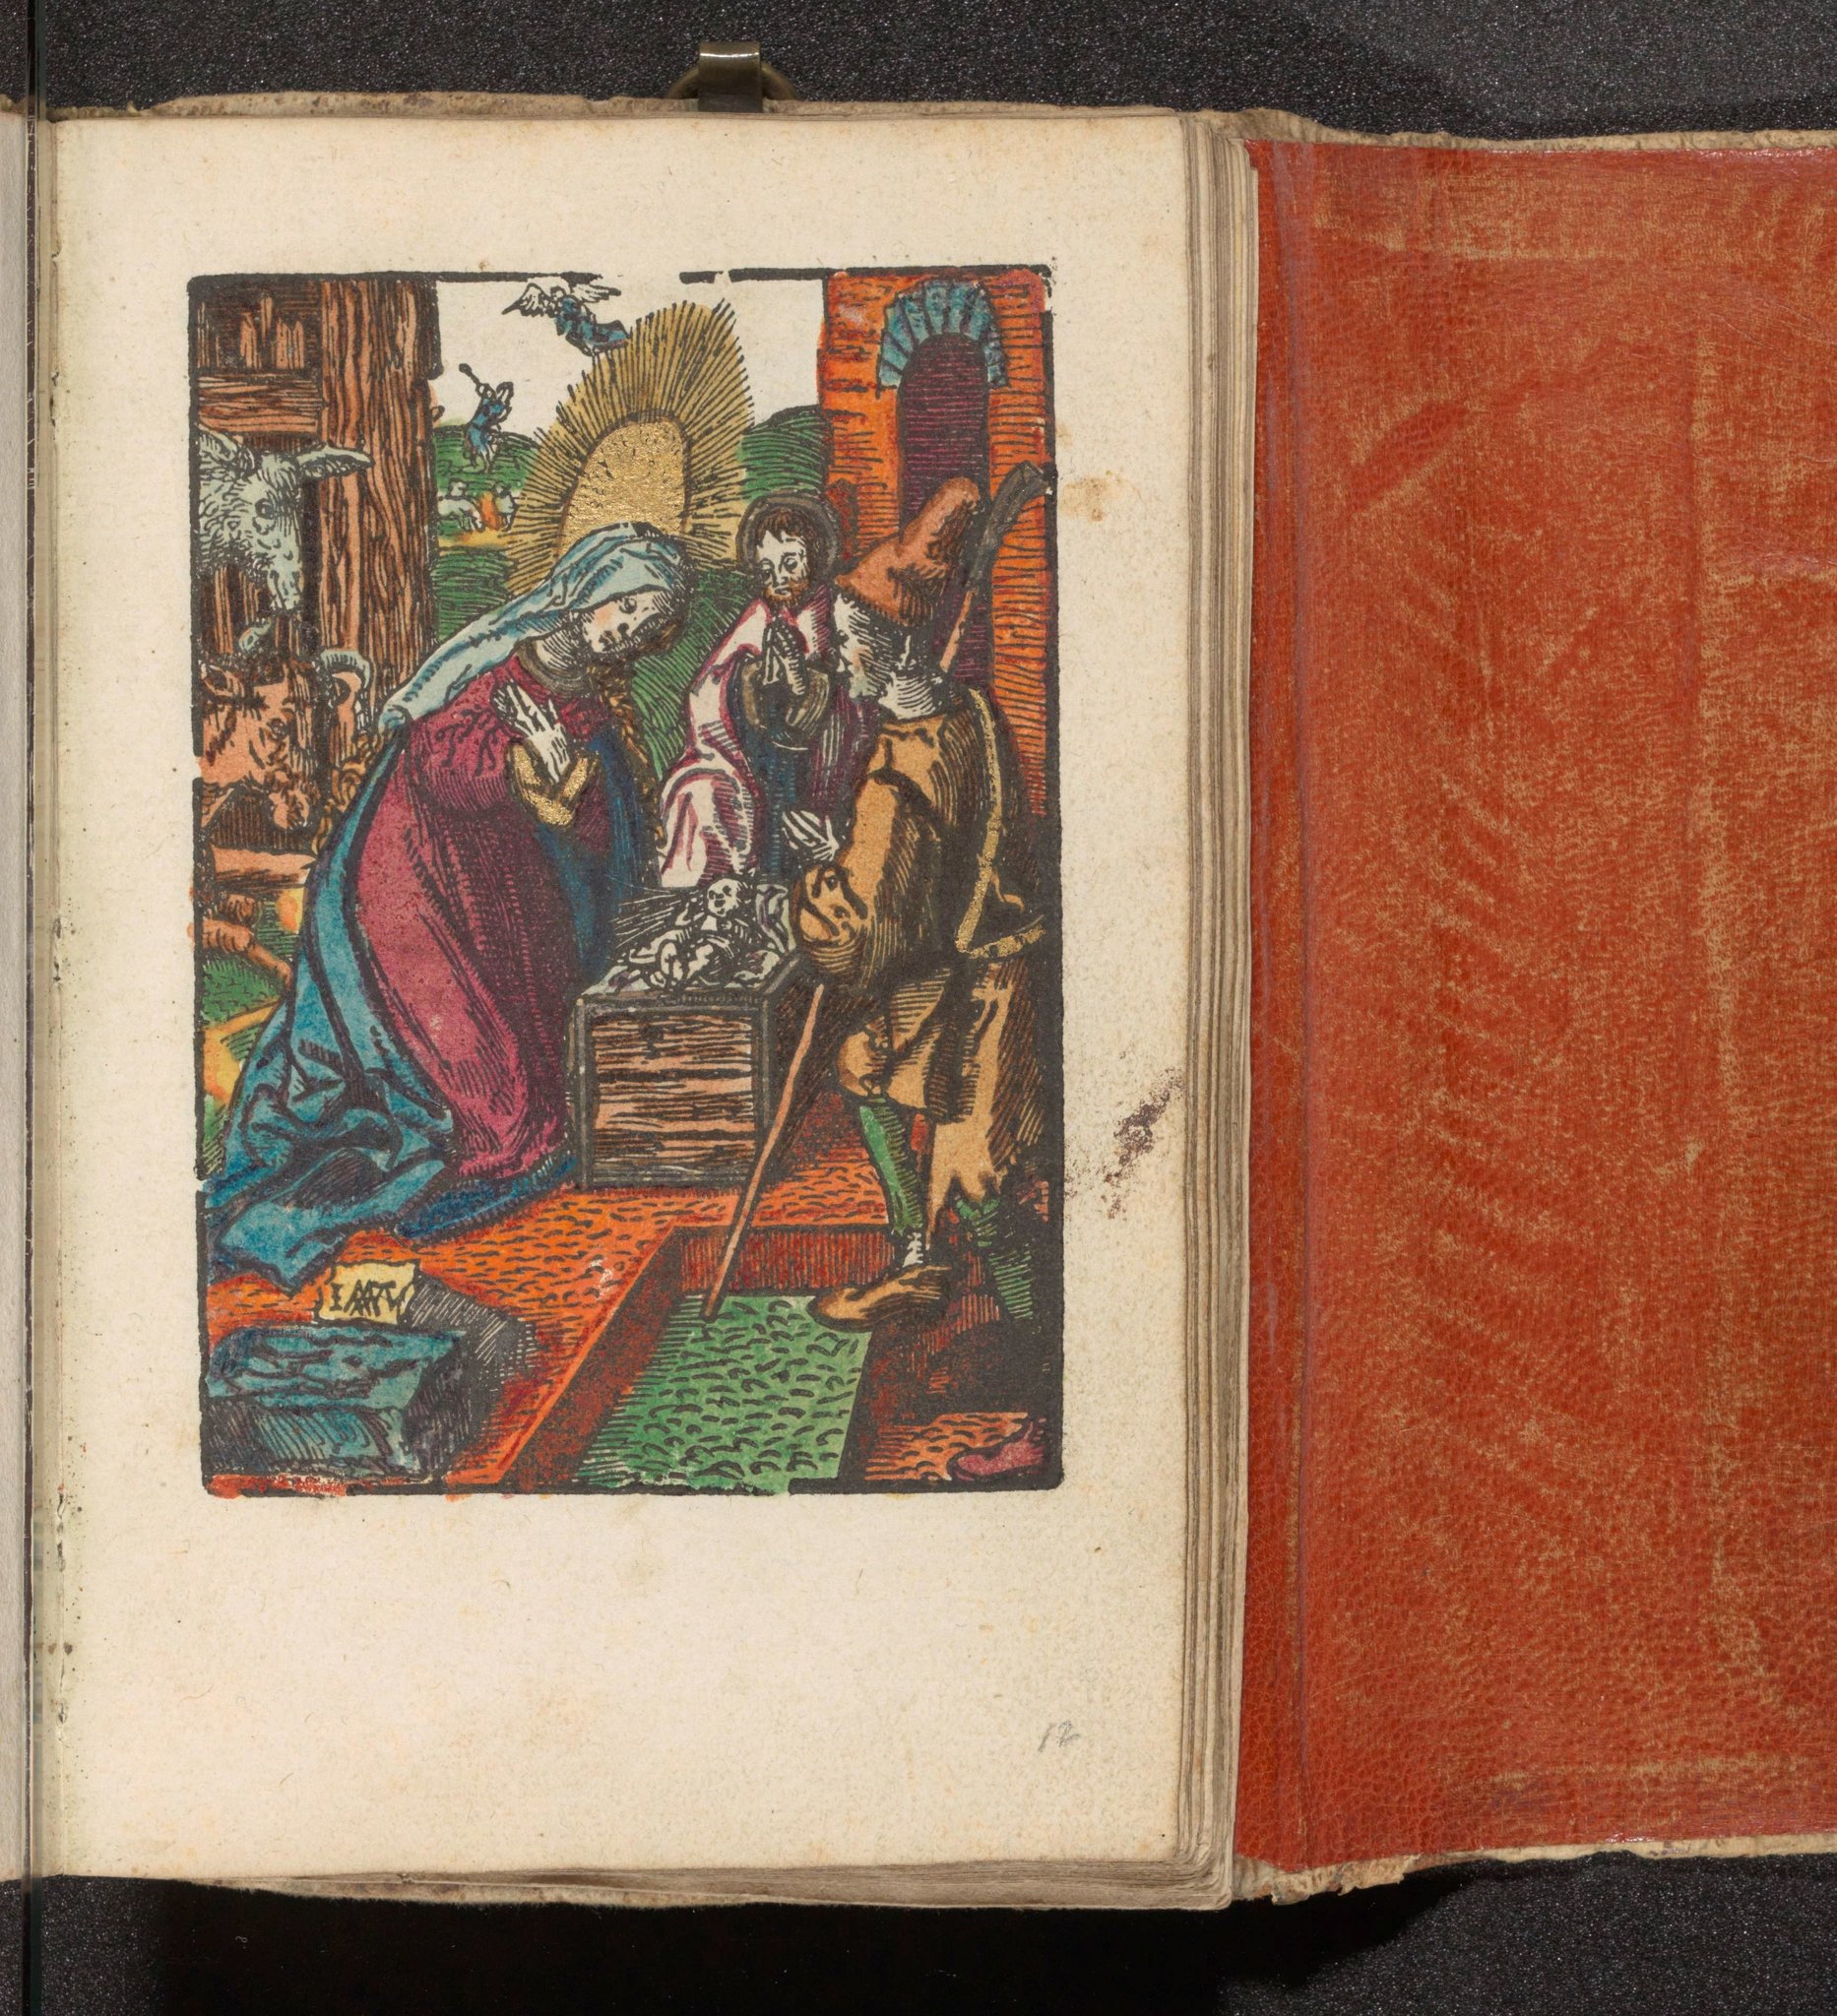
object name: book illustration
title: Stomme Passie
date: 1520-1521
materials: paper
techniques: hand coloring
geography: amsterdam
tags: adoration of the christ-child by mary and joseph, book in which illustrations are essential, mary, joseph and the new-born christ (nativity)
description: Maria, Jozef en een herder knielen rond het Christuskind dat in een houten voederbak ligt. Links de ezel en de os. Op de achtergrond de aankondiging aan de herders. Prent maakt deel uit van een boek.